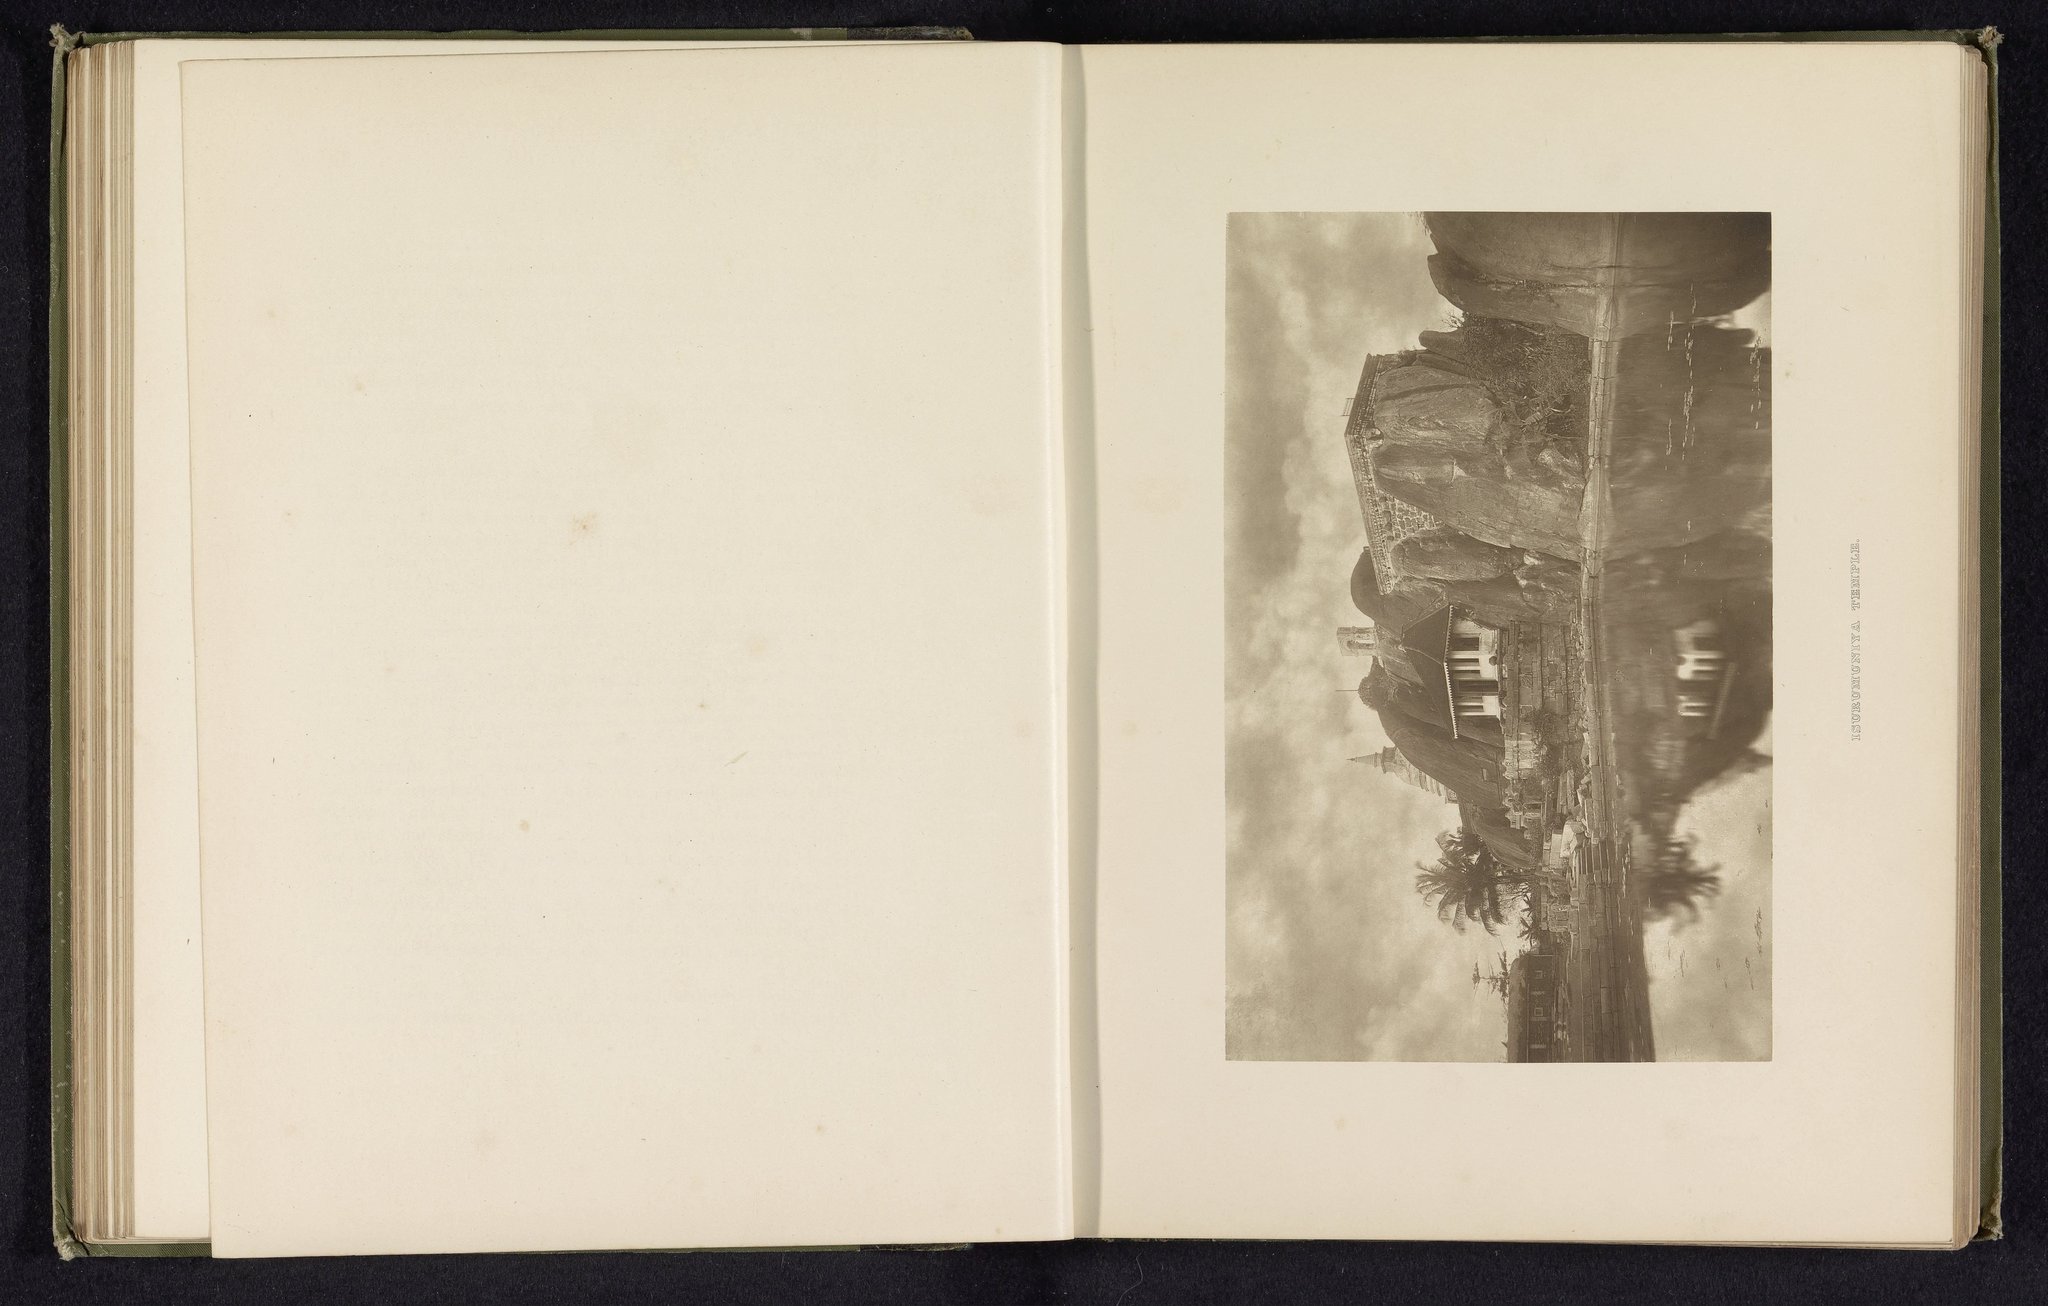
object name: photomechanical print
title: View of the Isurumuniya temple at Anuradhapura, Sri Lanka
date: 1896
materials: paper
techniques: woodburygravure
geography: anuradhapura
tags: temple, shrine ~ hinduism, buddhism, jainism, pond, pool, façade (of house or building)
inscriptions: title: ‘ISURUMUNIYA TEMPLE.’